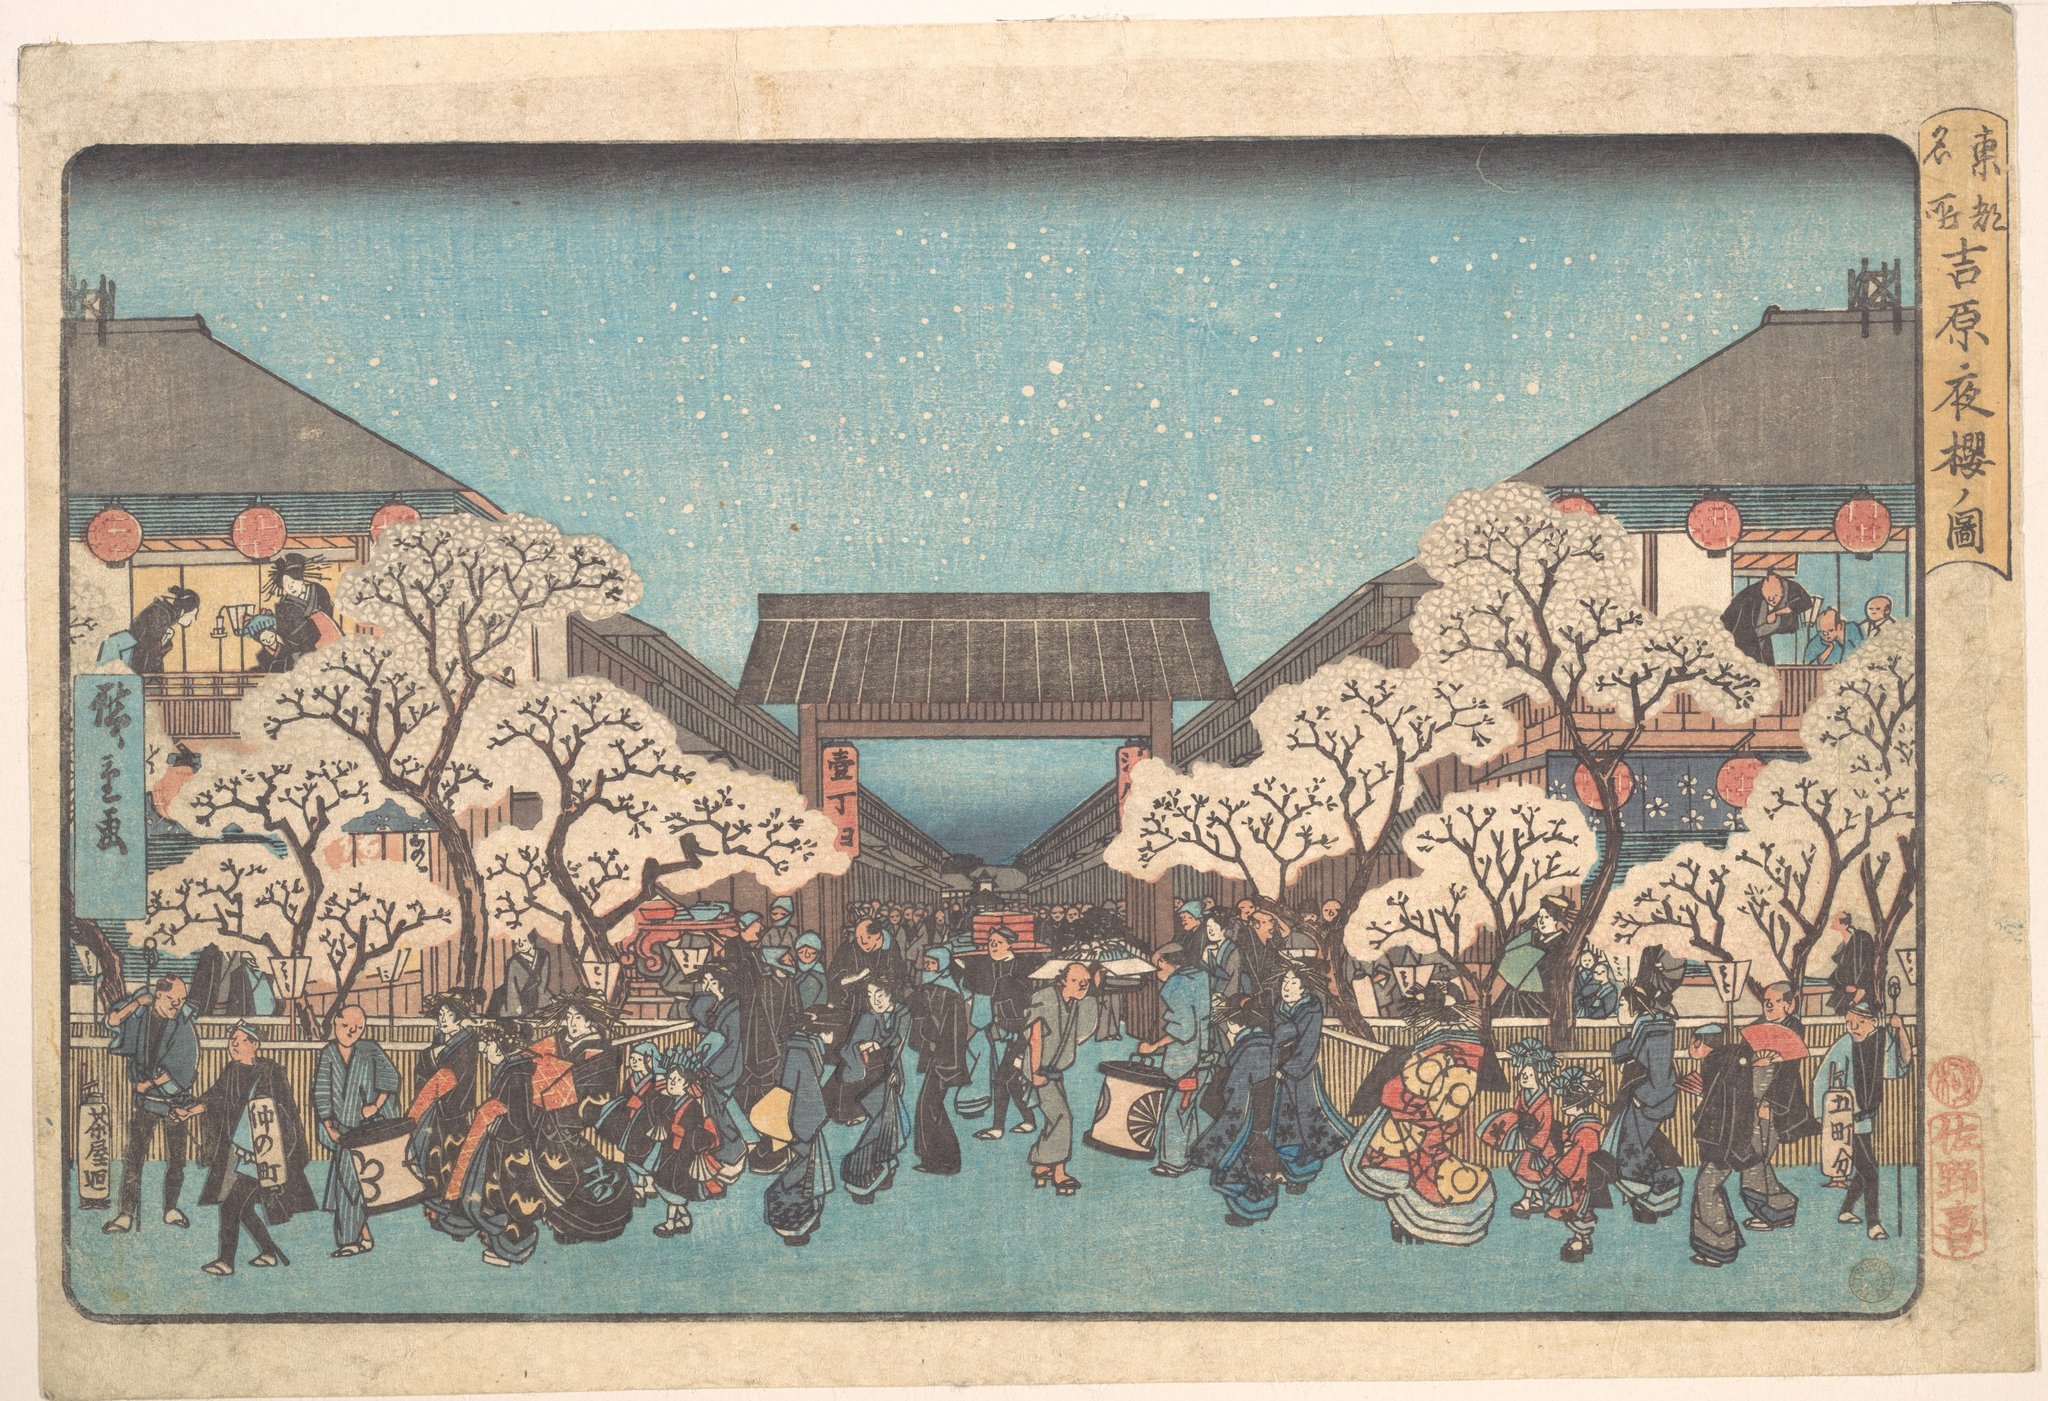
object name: print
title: Yoshiwara Yo Zakura no Zu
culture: japanese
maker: utagawa hiroshige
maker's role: artist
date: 1841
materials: ink, paper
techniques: woodblock print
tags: houses,men,women,trees